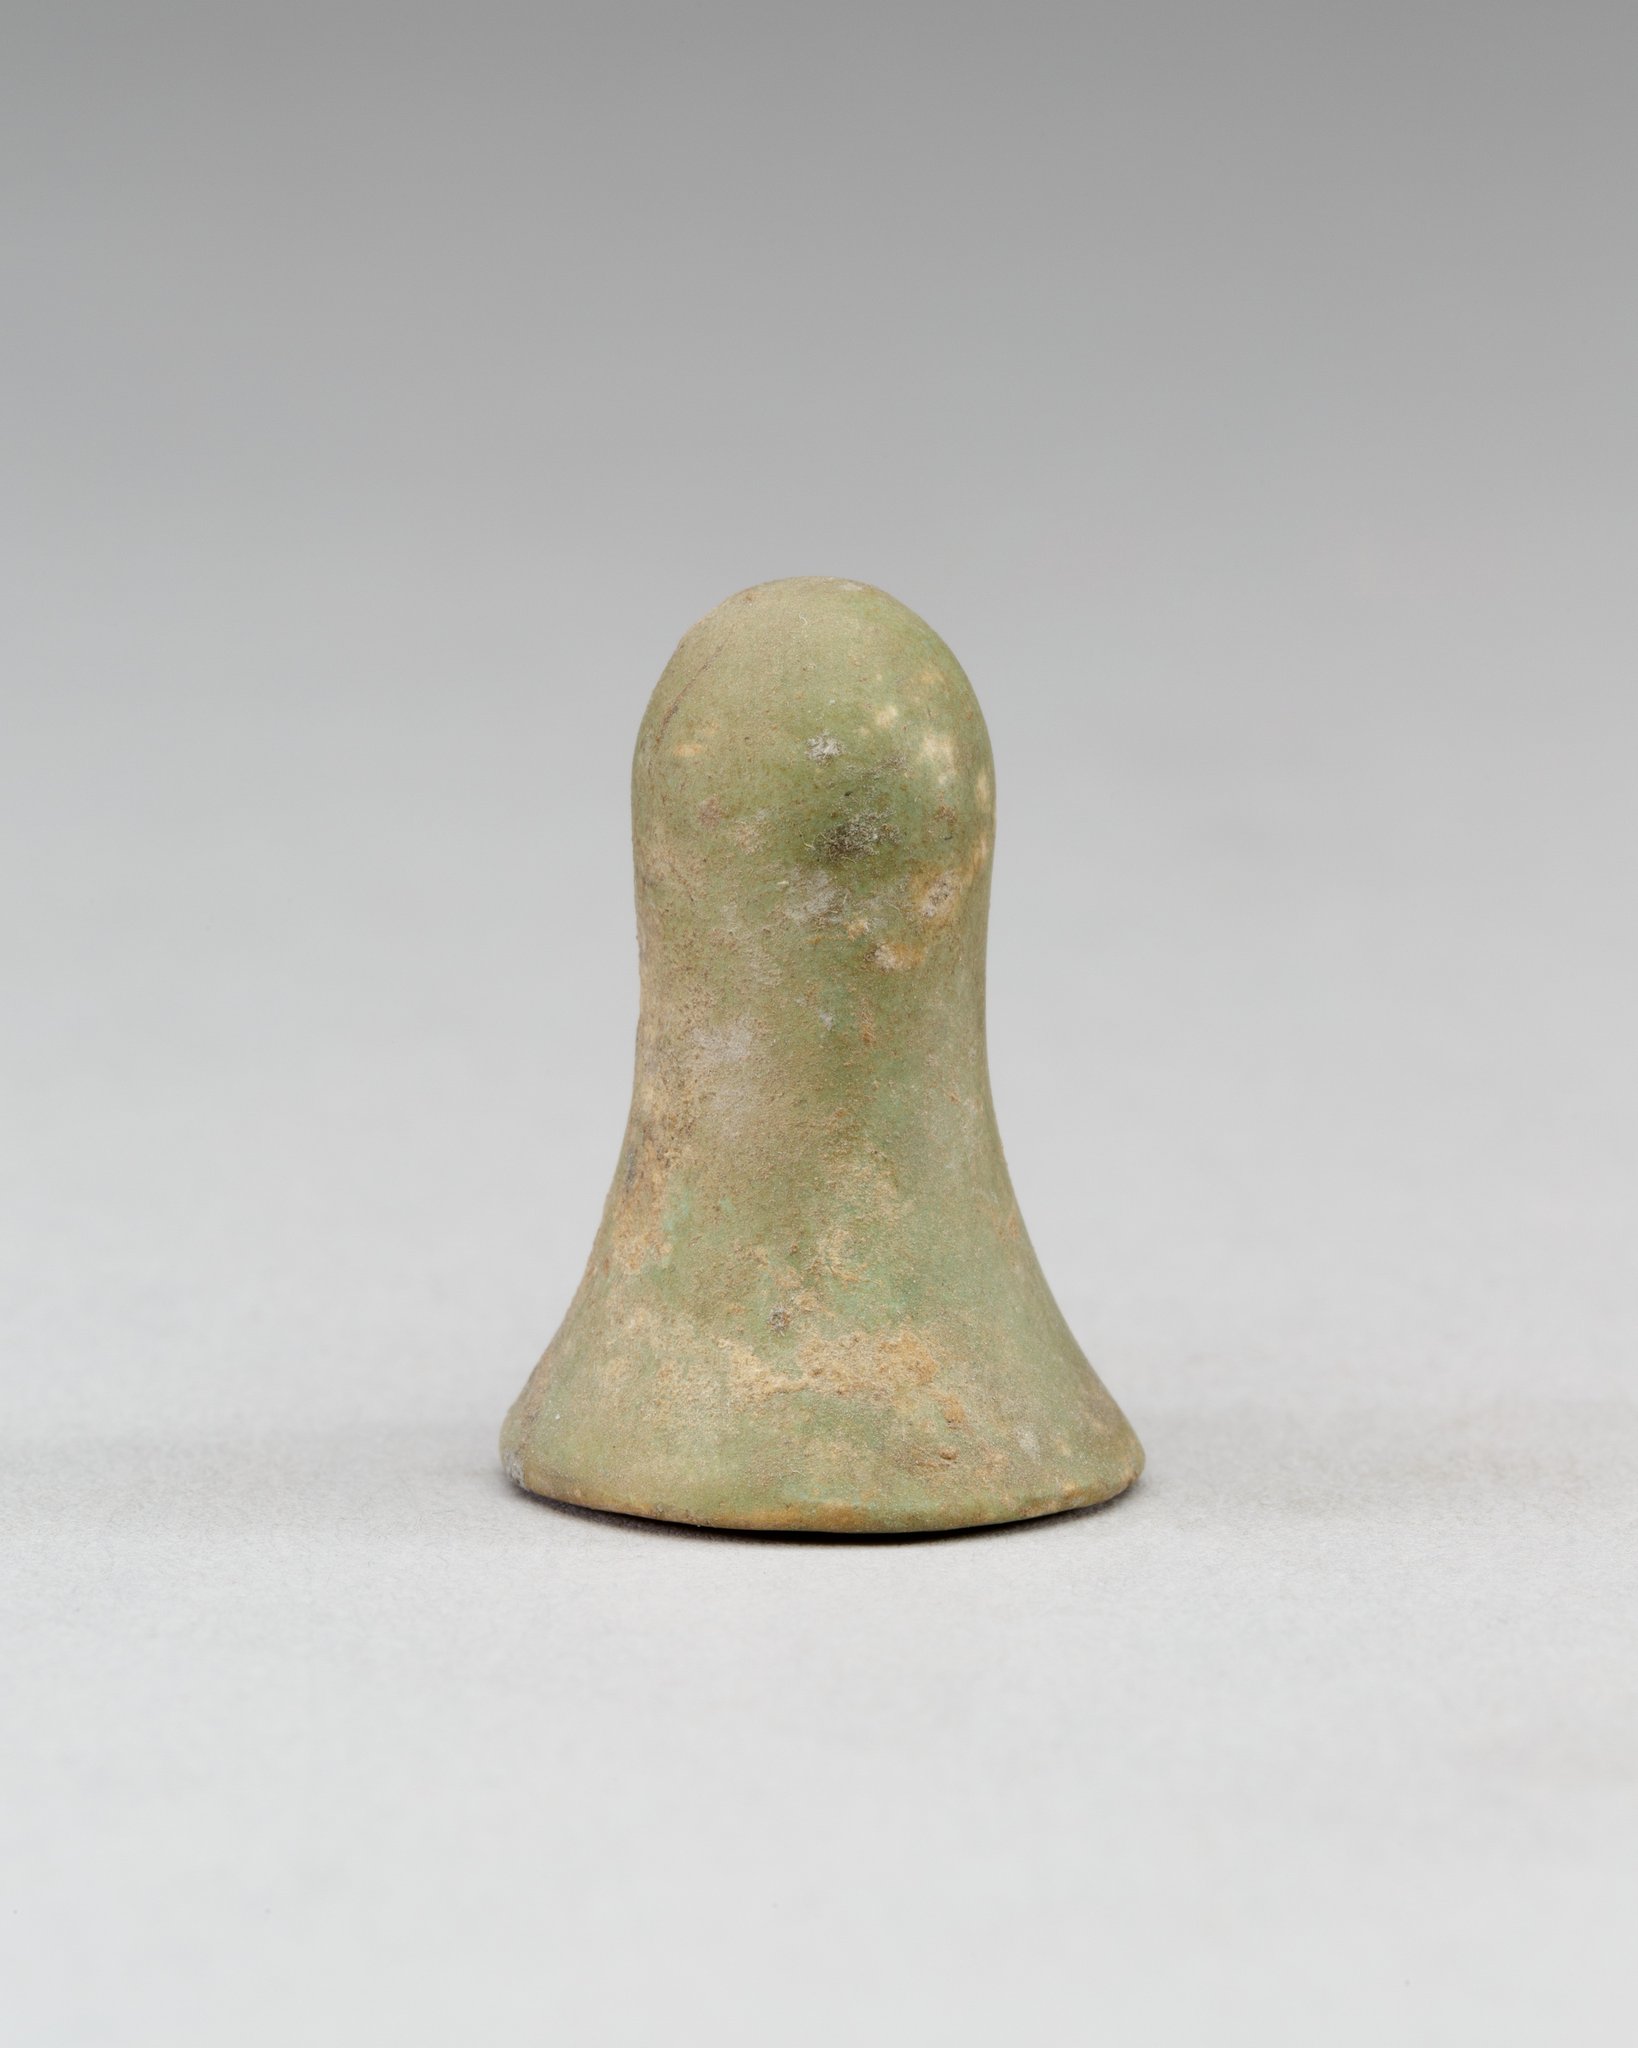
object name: game piece, conical, burial 8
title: Conical Gaming Piece from Neferkhawet's Tomb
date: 1504-1447 BCE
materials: faience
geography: egypt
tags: games